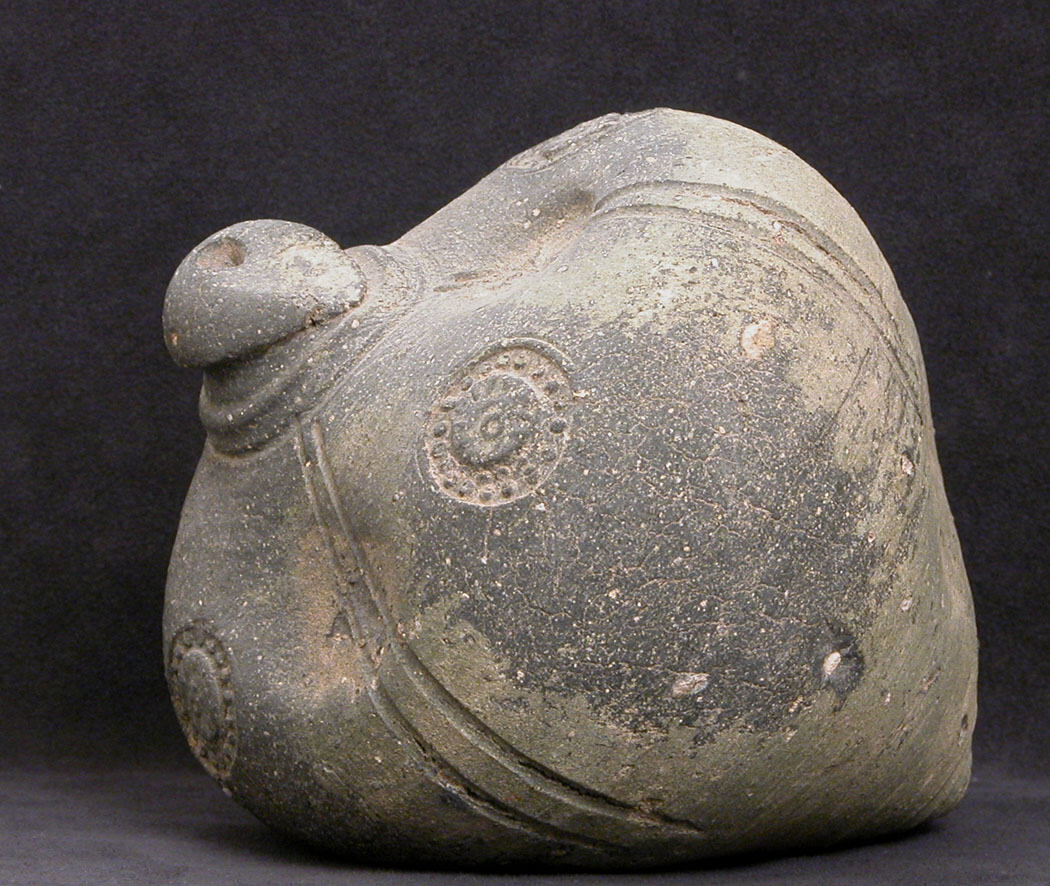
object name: vessel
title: Spheroconical Vessel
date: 801-1000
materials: earthenware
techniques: incising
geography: iran